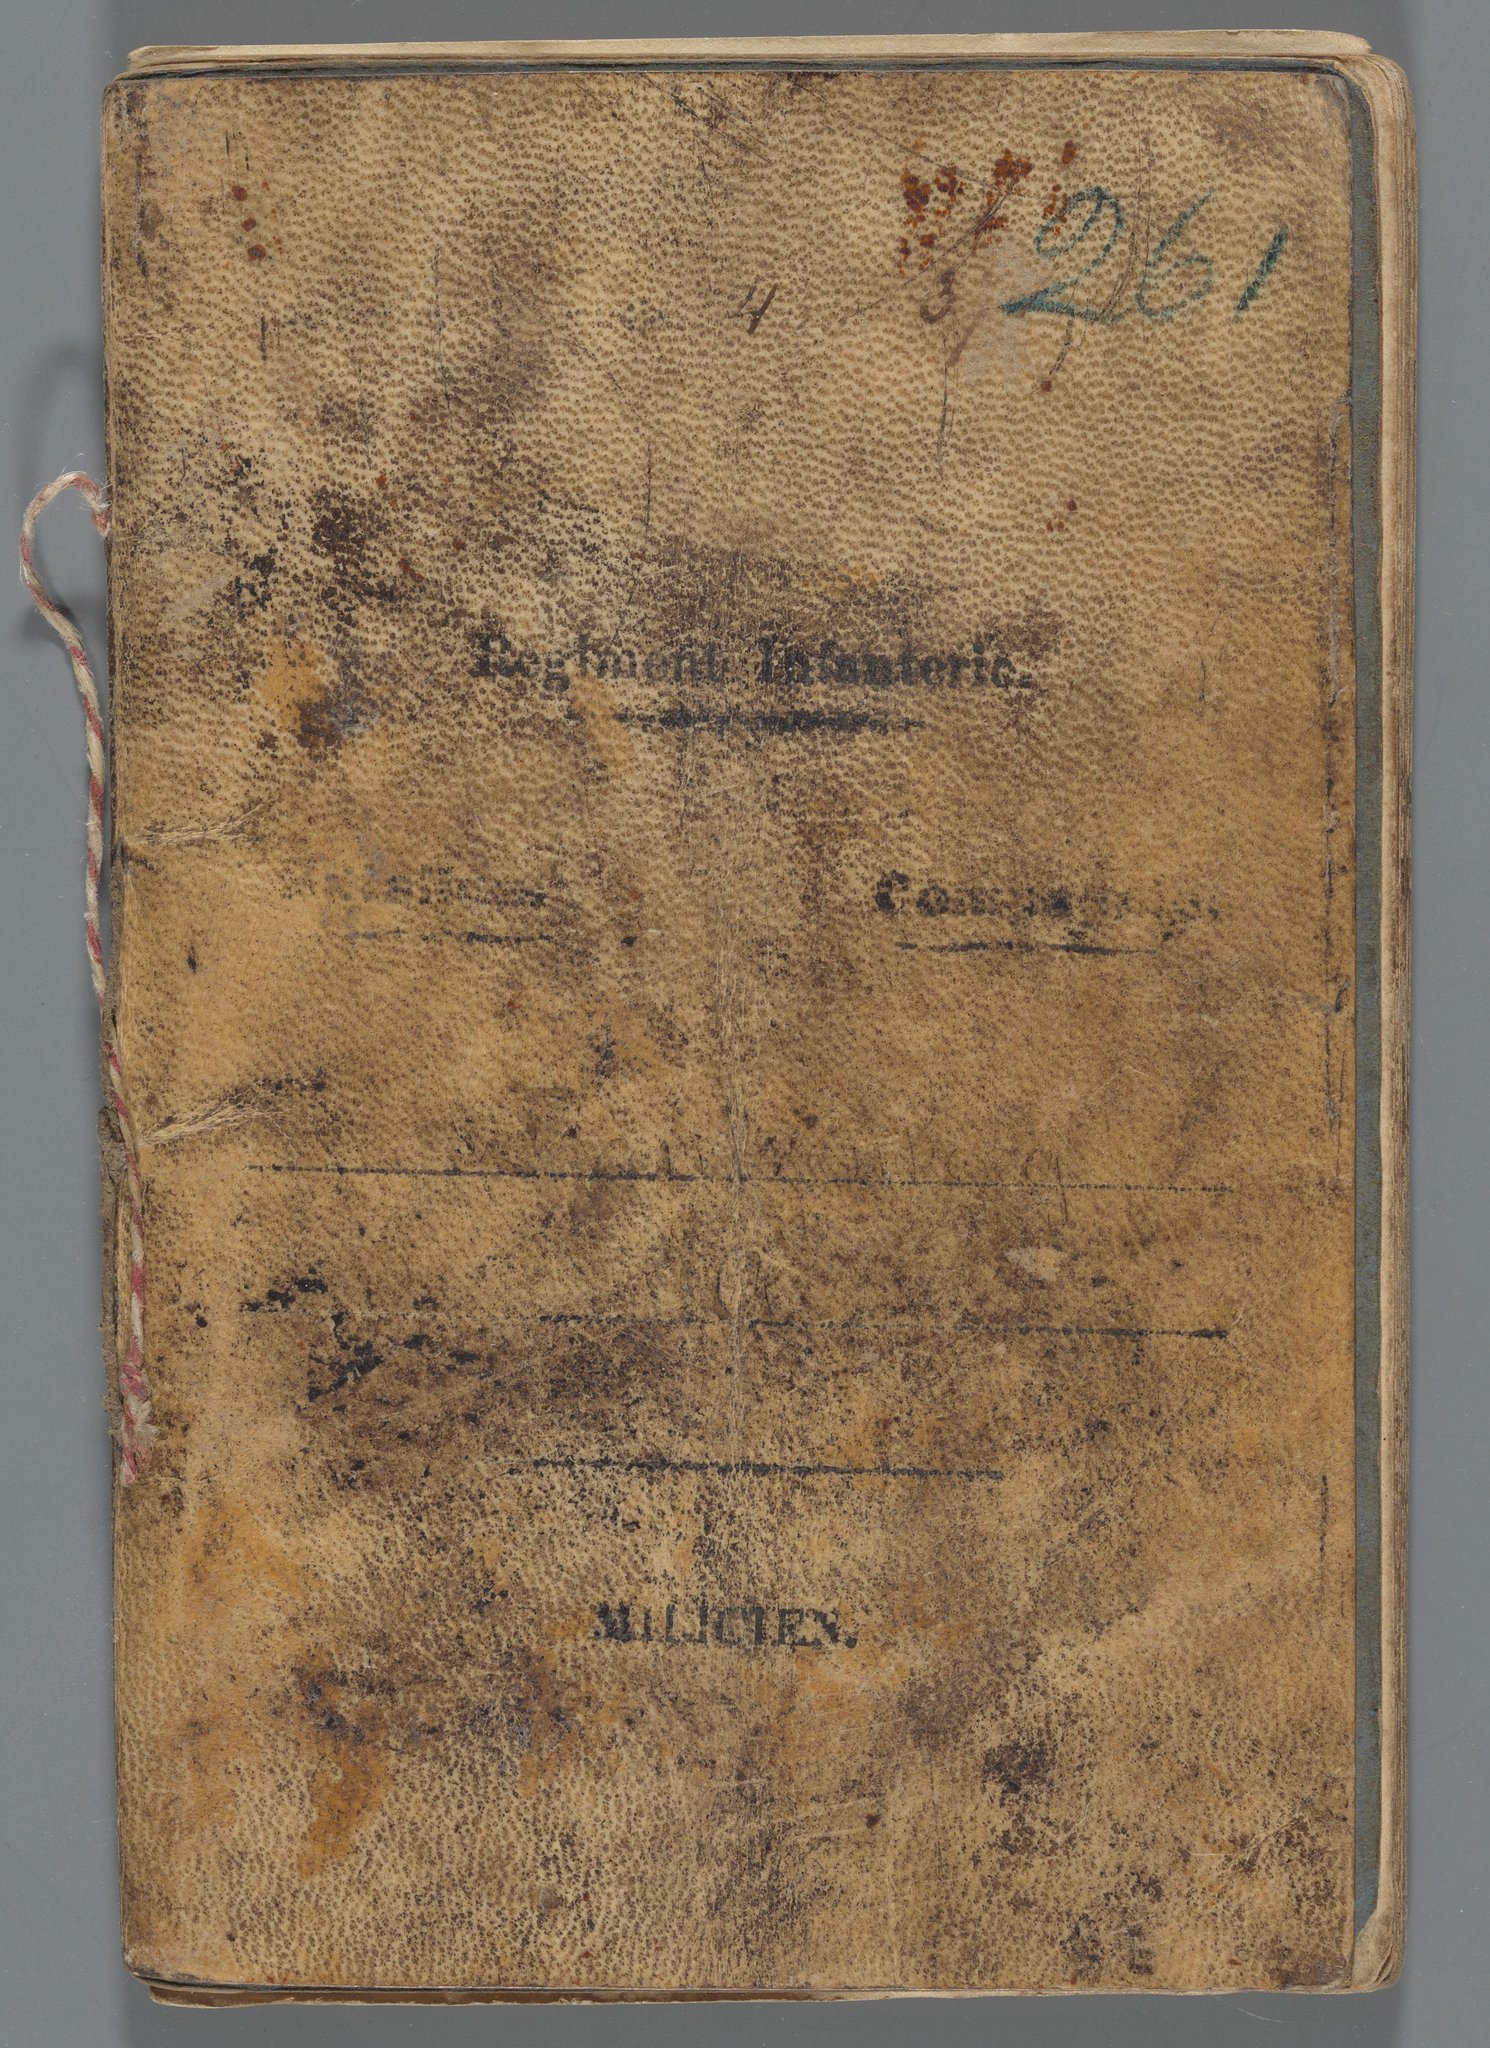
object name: paybook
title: Militair zakboekje van Andreas Dautzenberg, 1896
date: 1896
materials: paper, parchment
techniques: handwriting, printed materials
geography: netherlands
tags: andreas dautzenberg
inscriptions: collector's mark: Lugt 2228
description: Militair zakboekje van Andreas Dautzenberg, milicien soldaat in het 4e Compagnie 2e Bataljon 2e Regiment Infanterie. Afgegeven te Maastricht op 10 maart 1896, met aantekeningen tot en met het jaar 1904.